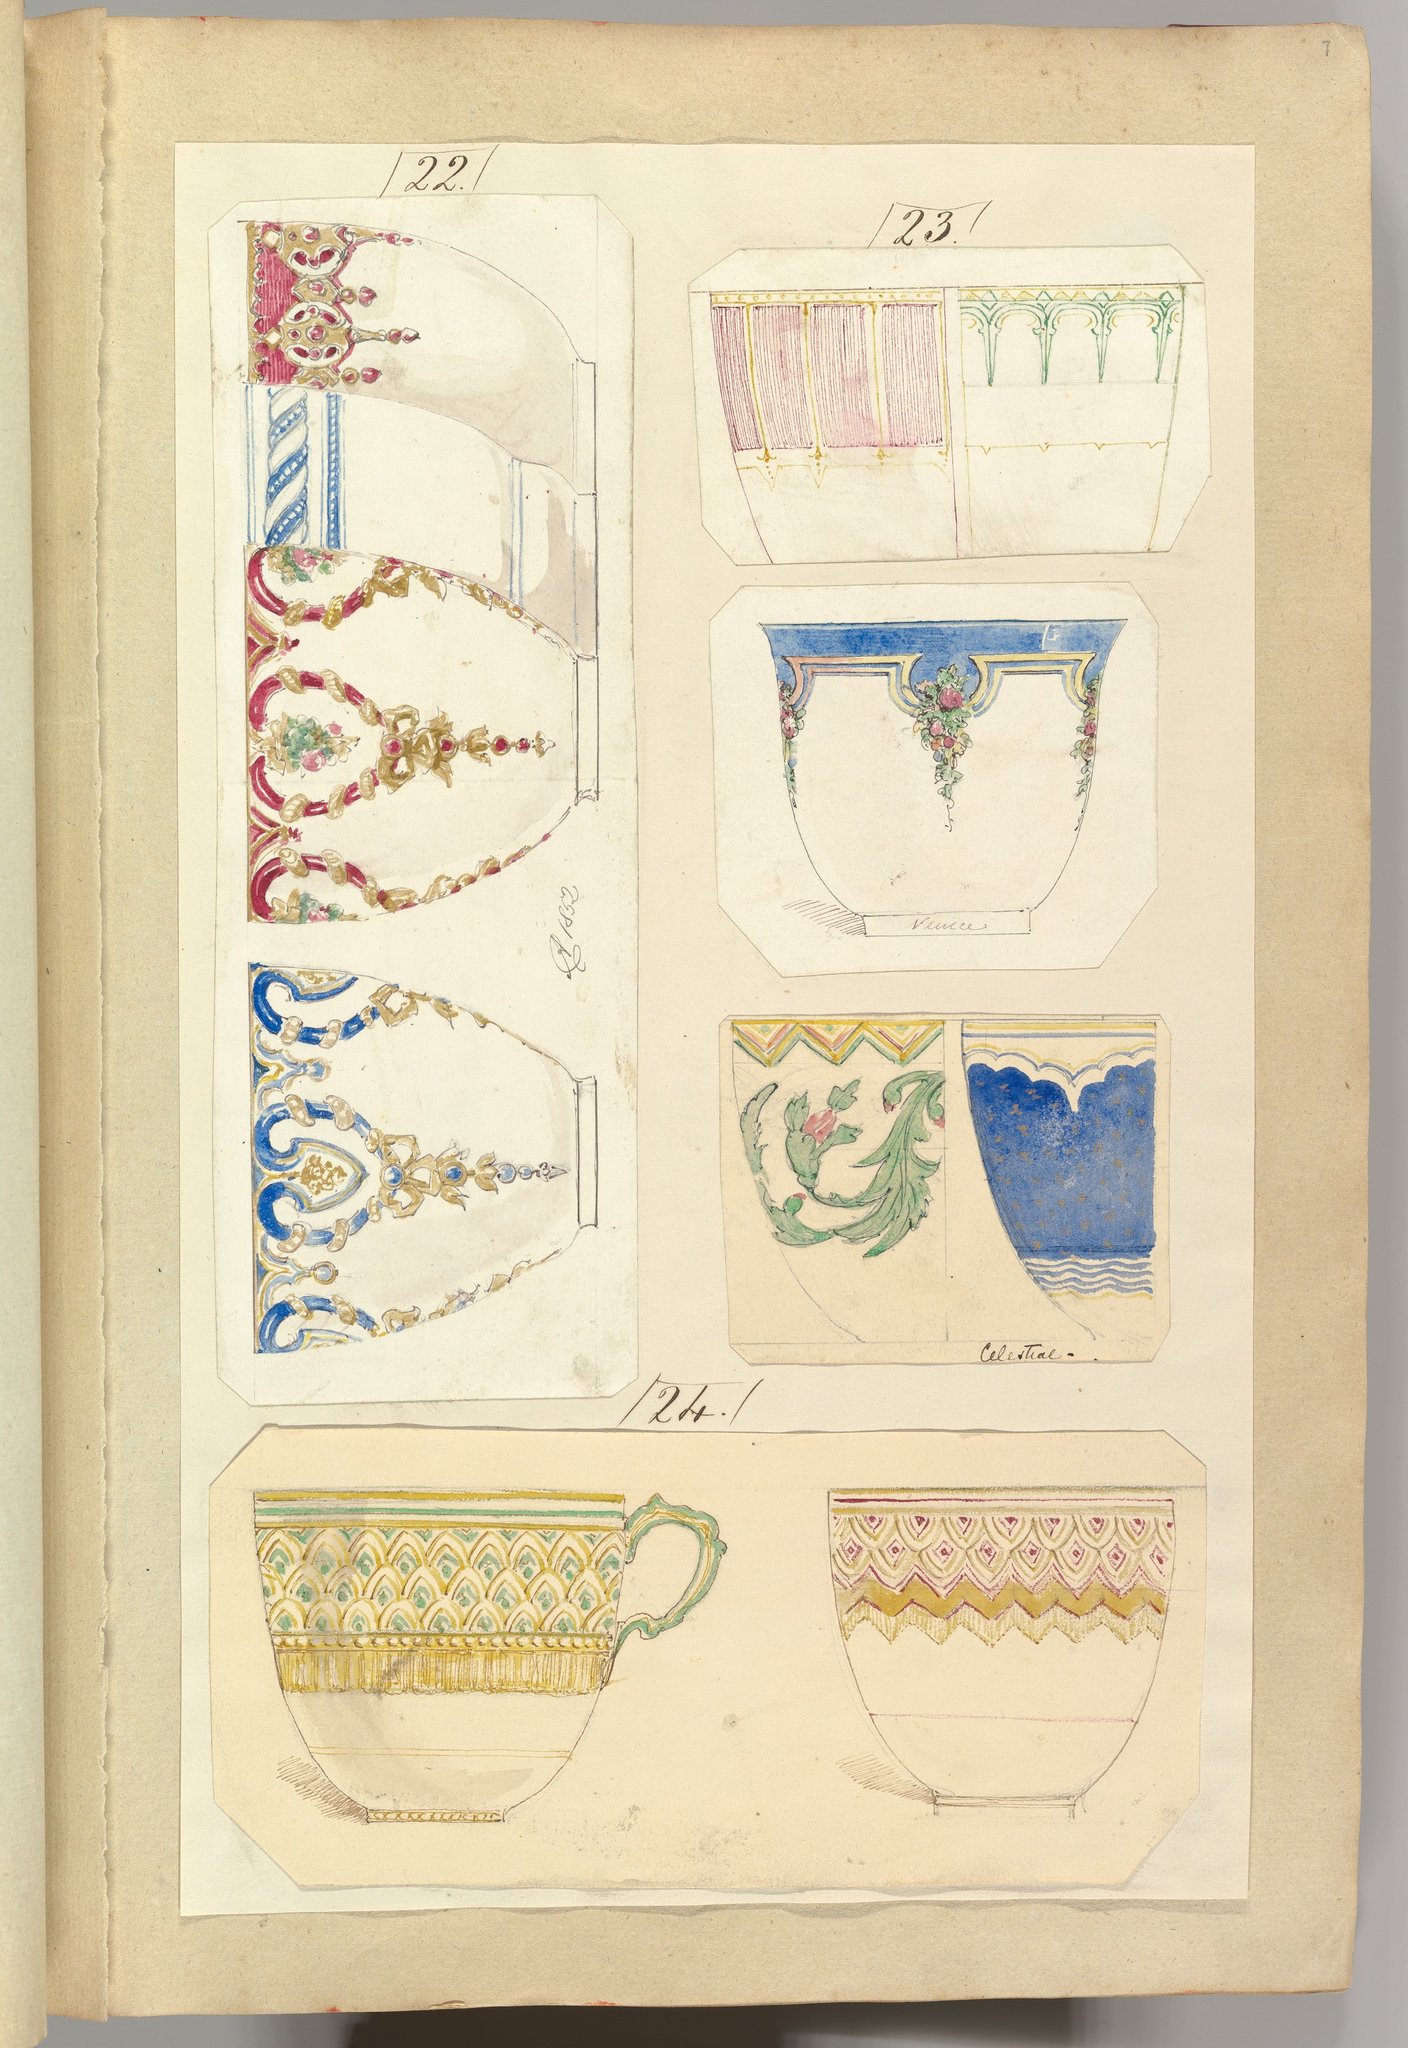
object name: drawing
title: Eleven Designs for Decorated Cups, including Venice and Celestial Patterns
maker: alfred henry forrester [alfred crowquill]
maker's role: artist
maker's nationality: british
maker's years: 1804-1872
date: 1852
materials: gouache, ink, watercolor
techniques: pen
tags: flowers,cups